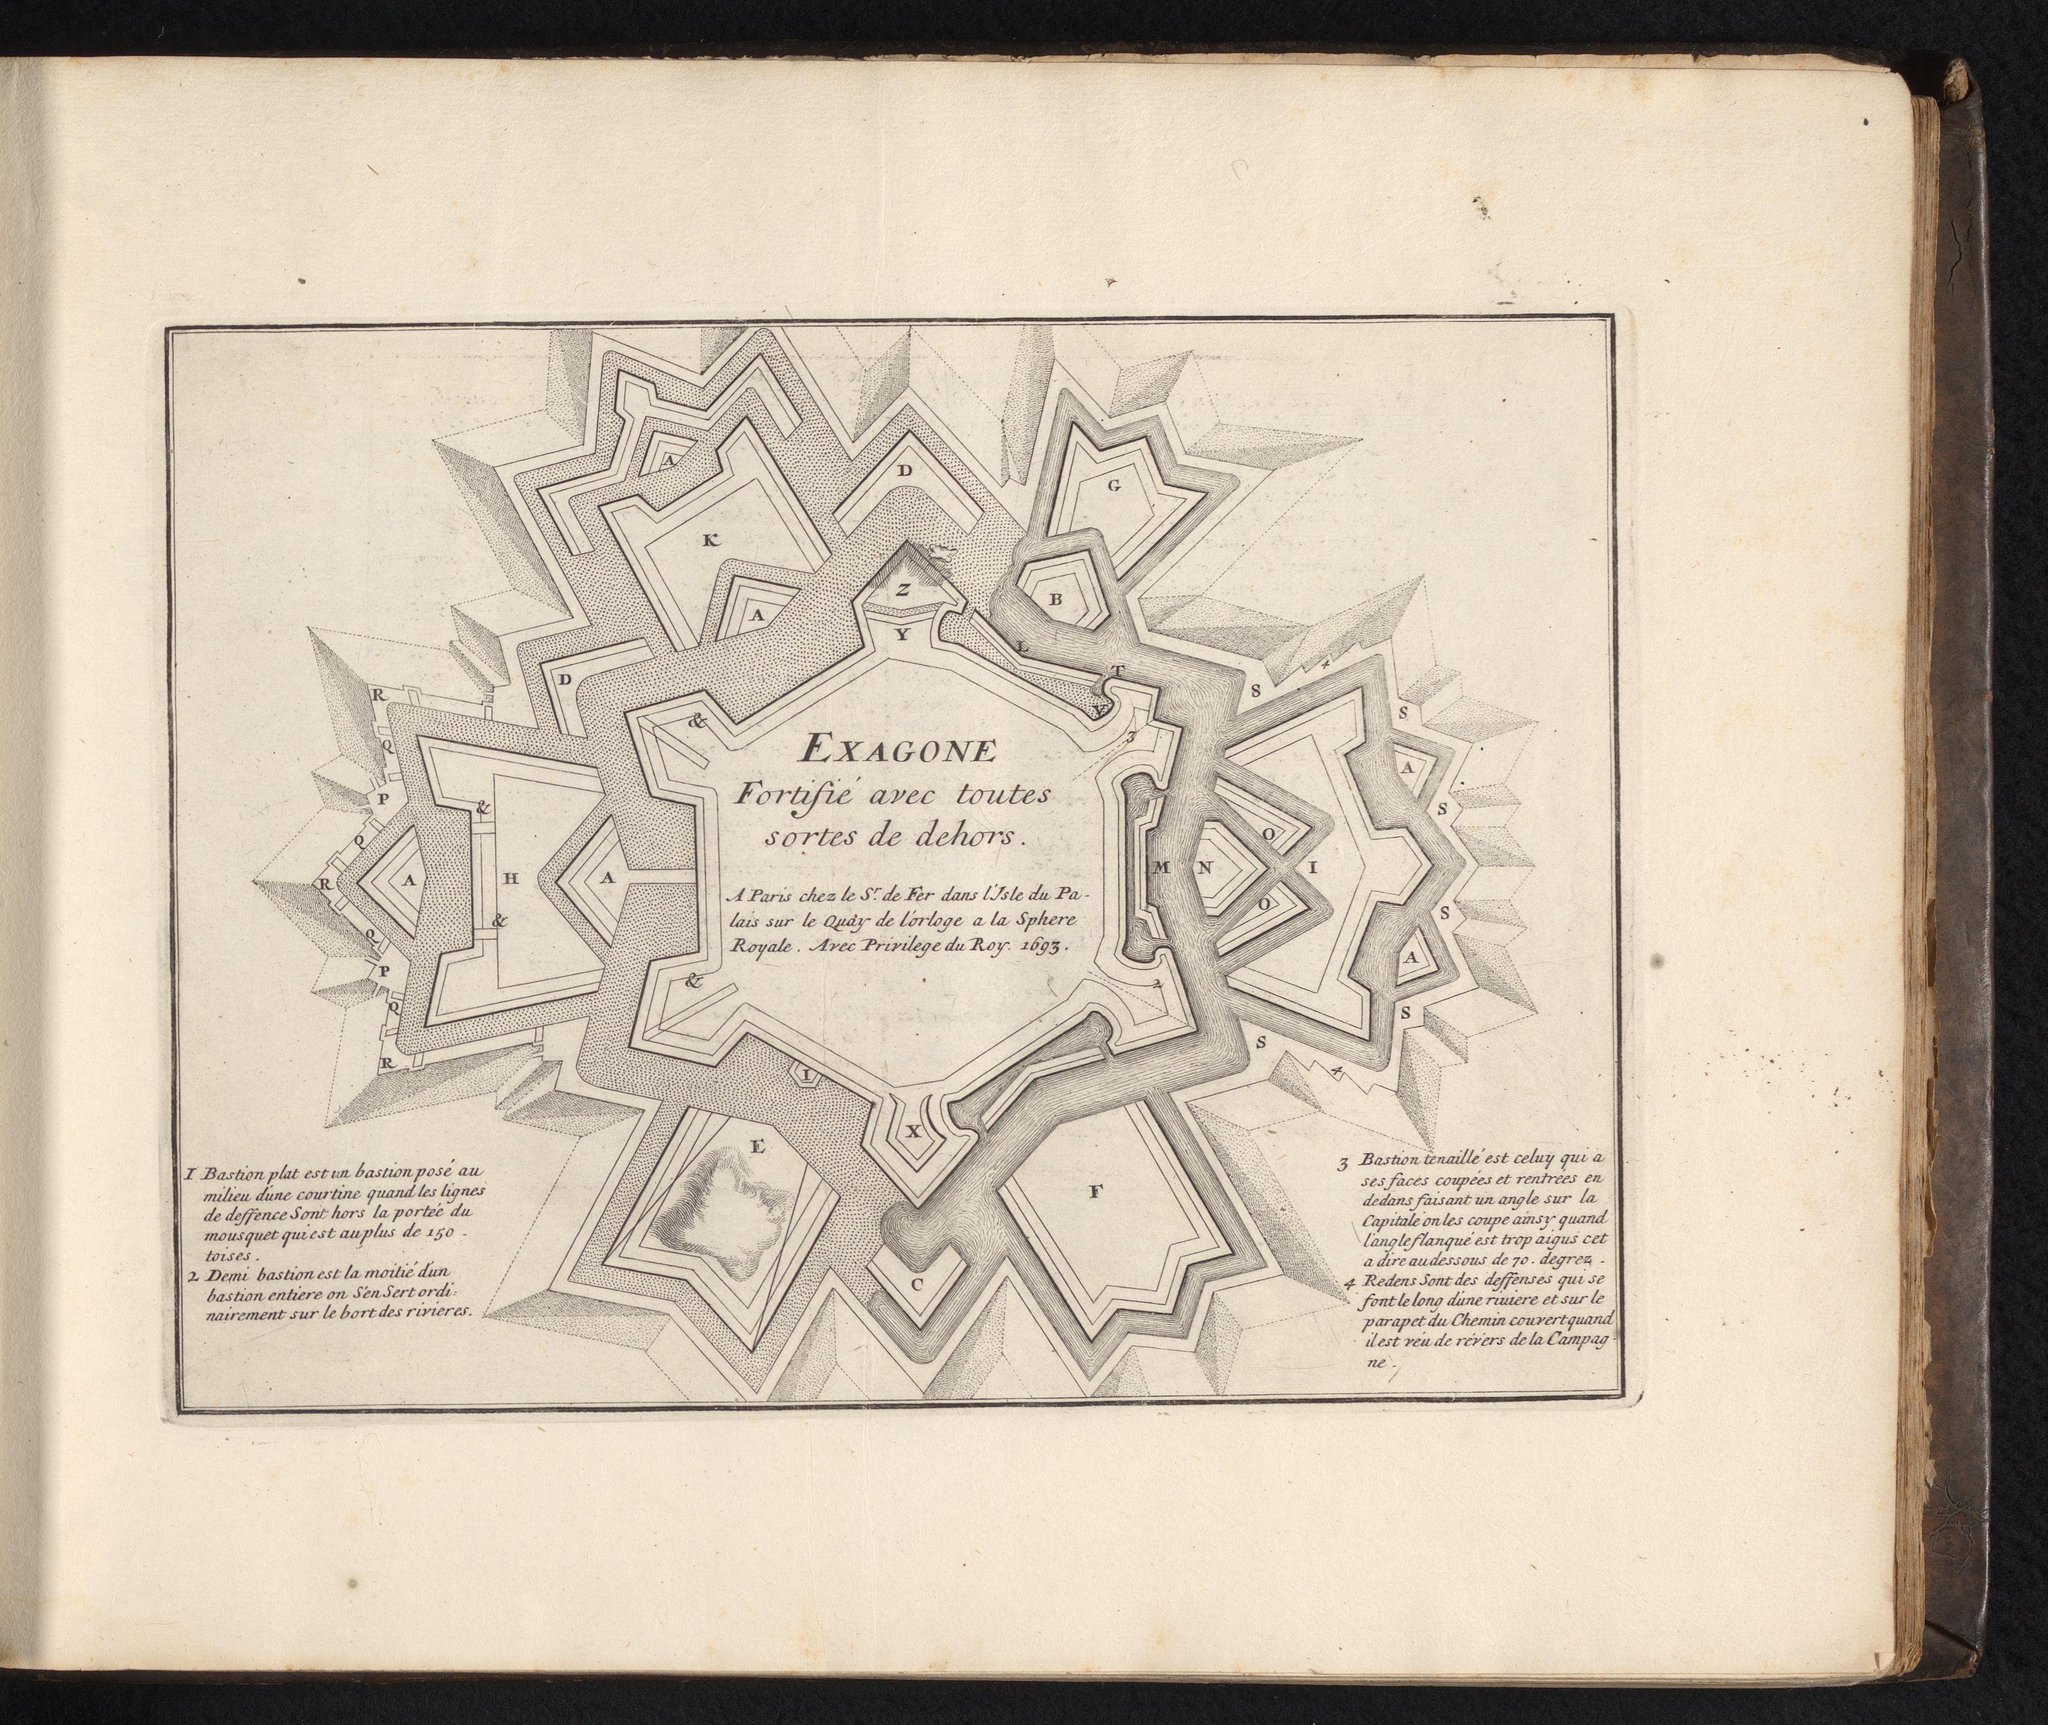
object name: print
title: Definitions des dehors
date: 1693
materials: paper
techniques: engraving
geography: paris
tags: negenjarige oorlog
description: Termenlijst behorend bij de vijfde plaat over de toepassing van het figuur van de zeshoek in de vestingbouw. Onderdeel van het eerste deel (1693) van het prentwerk waarin gebundeld zijn de acht delen van Les forces de l'Europe uitgegeven tussen 1693-1697. Het prentwerk bestaat uit 175 platen met plannen (afkomstig van Sébastien Le Prestre, Seigneur de Vauban) van vermaarde sterke steden en vestingen in de Negenjarige Oorlog. Titel in het Frans.